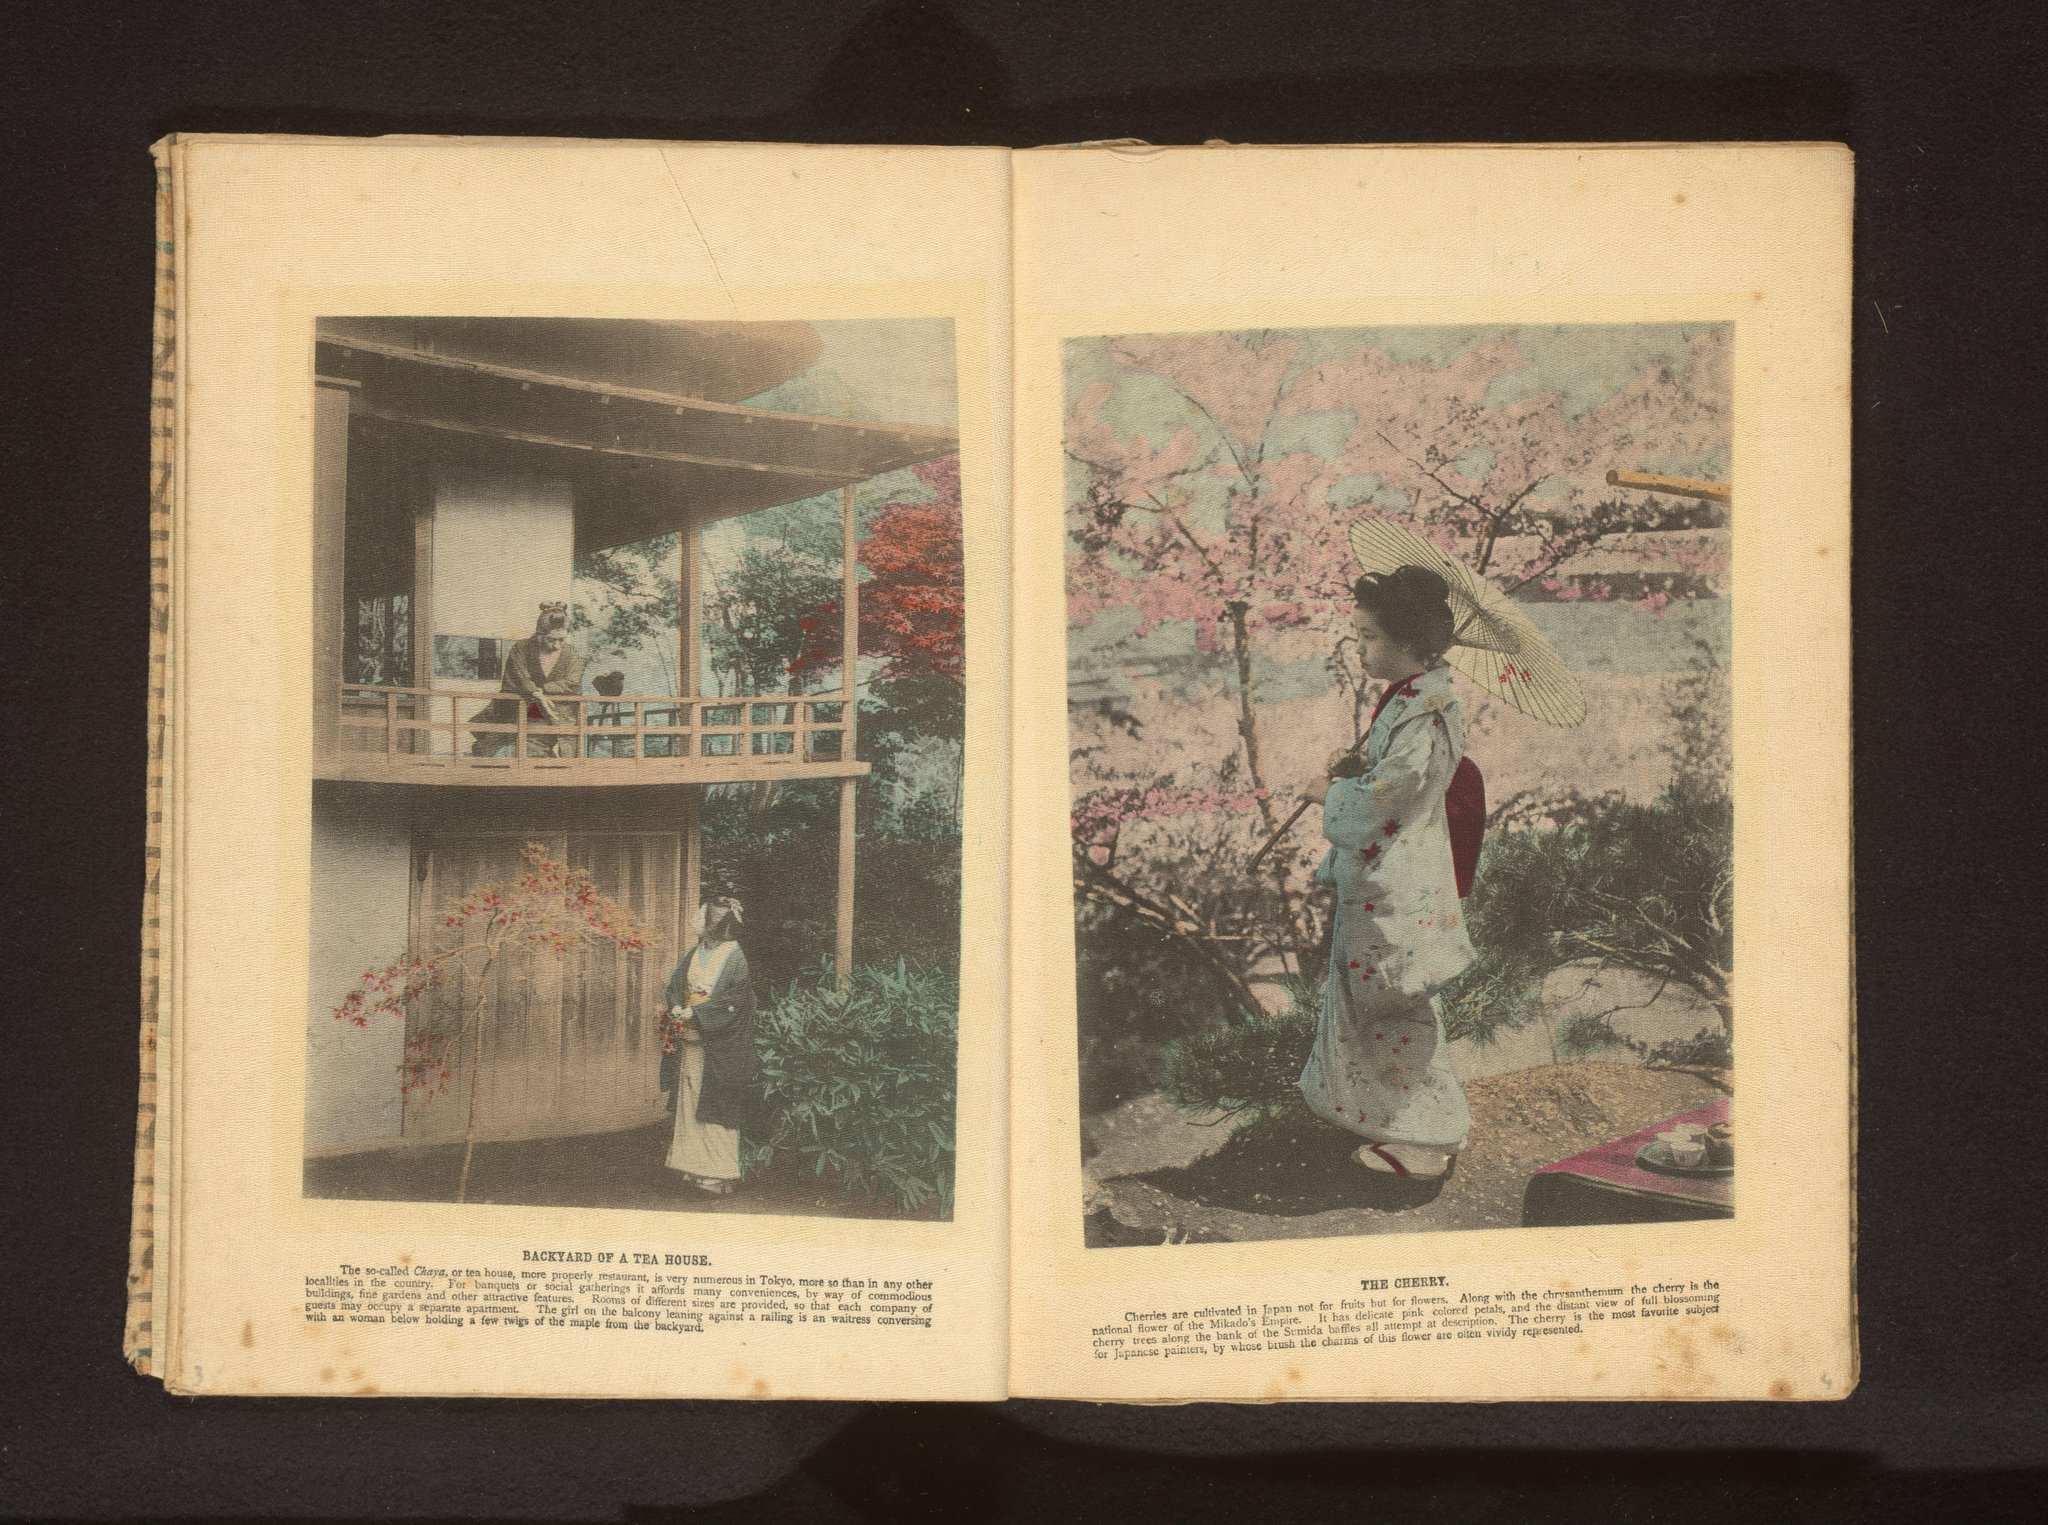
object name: page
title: Backyard of a tea house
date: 1886-1896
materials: paper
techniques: photograph, hand coloring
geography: japan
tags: adult woman, tea garden, garden restaurant, backyard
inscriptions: inscription: ‘The so-called Chaya (...) from the backyard.’